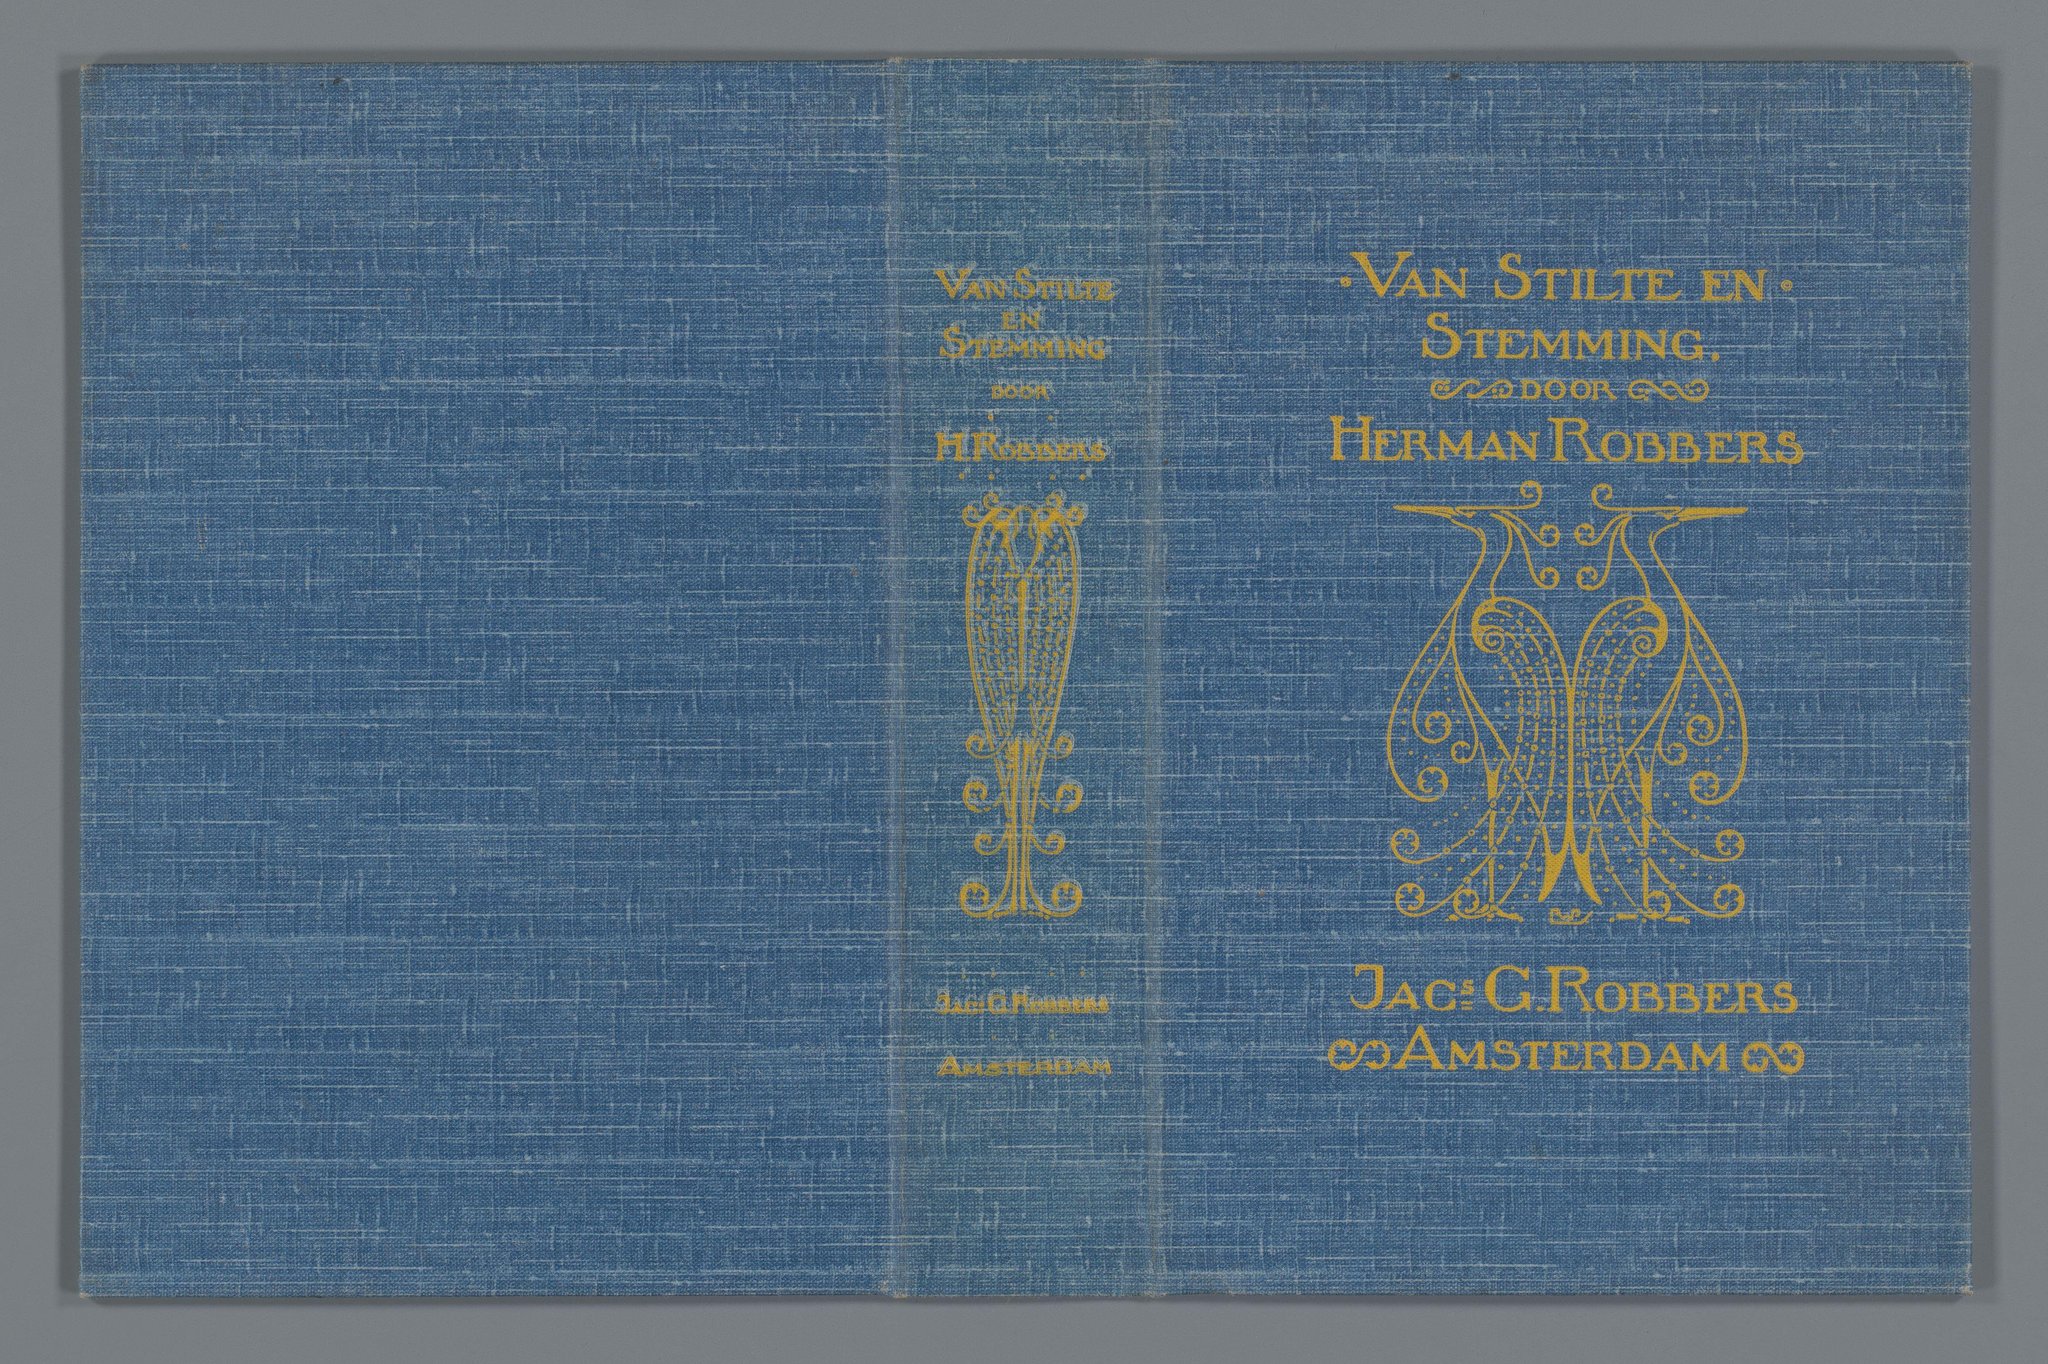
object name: binding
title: Boekband voor: Herman Robbers, Van stilte en stemming, 1905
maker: Anonymous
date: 1905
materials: cardboard, linen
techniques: printing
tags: birds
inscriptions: annotation: ‘Model/ rug iets smaller als/ aangegeven’, collector's mark: ‘R:MVS.’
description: Boekband voor: Robbers, Herman. Van stilte en stemming. Amsterdam: Robbers, 1905.